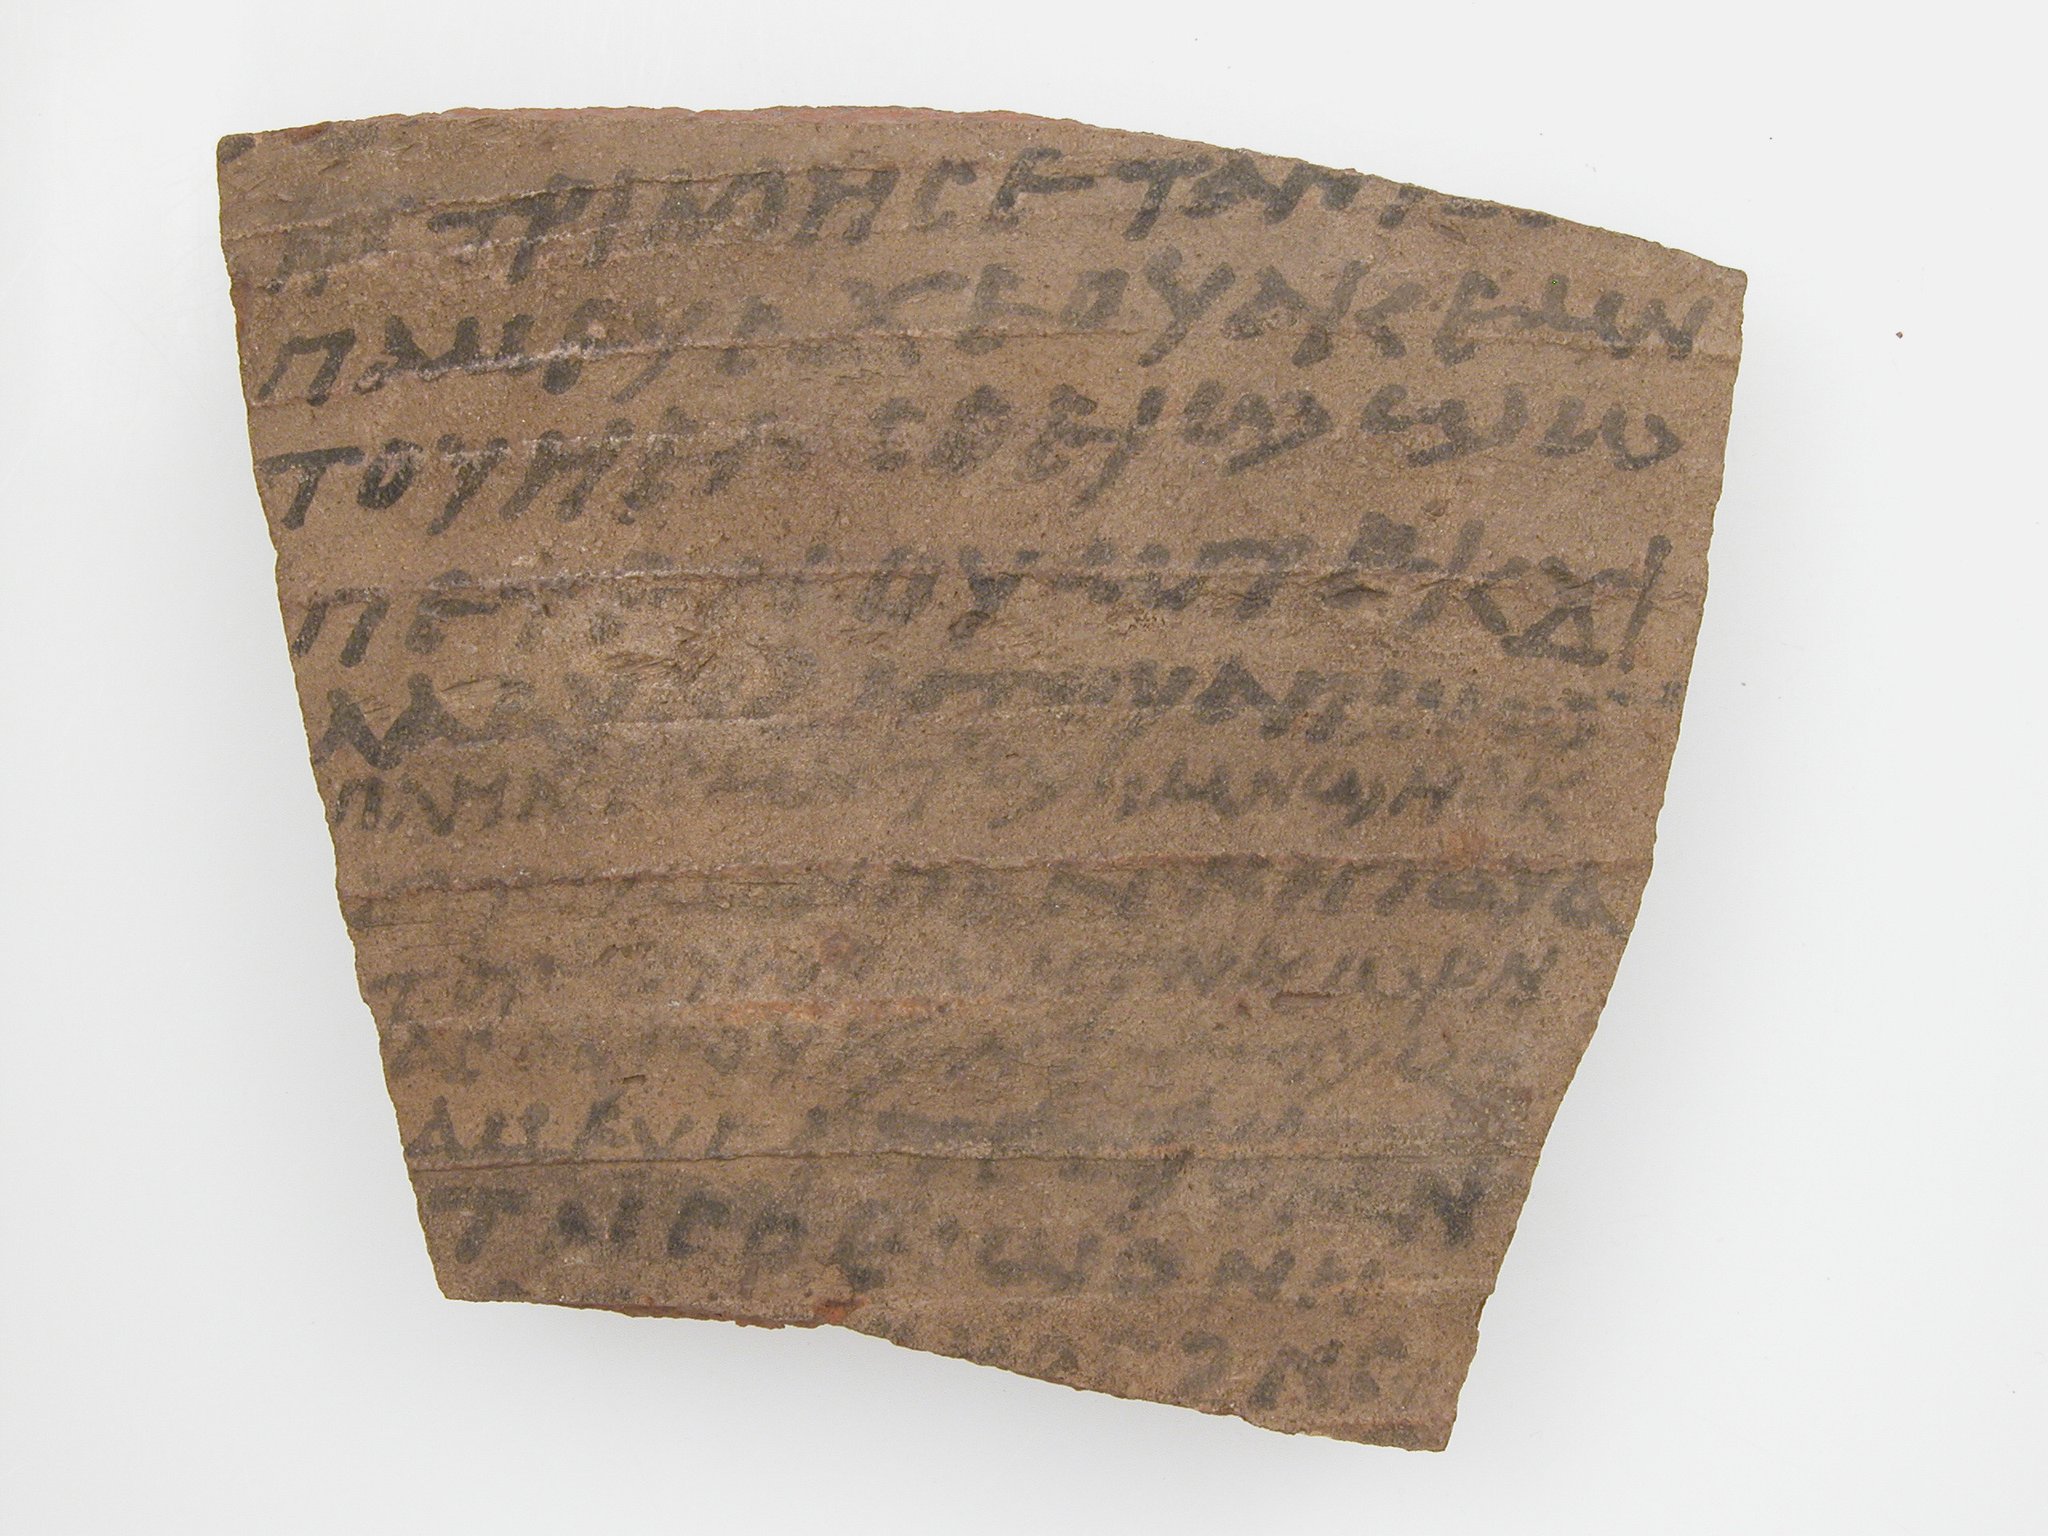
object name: ostrakon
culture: coptic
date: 601-700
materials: ink, pottery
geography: egypt